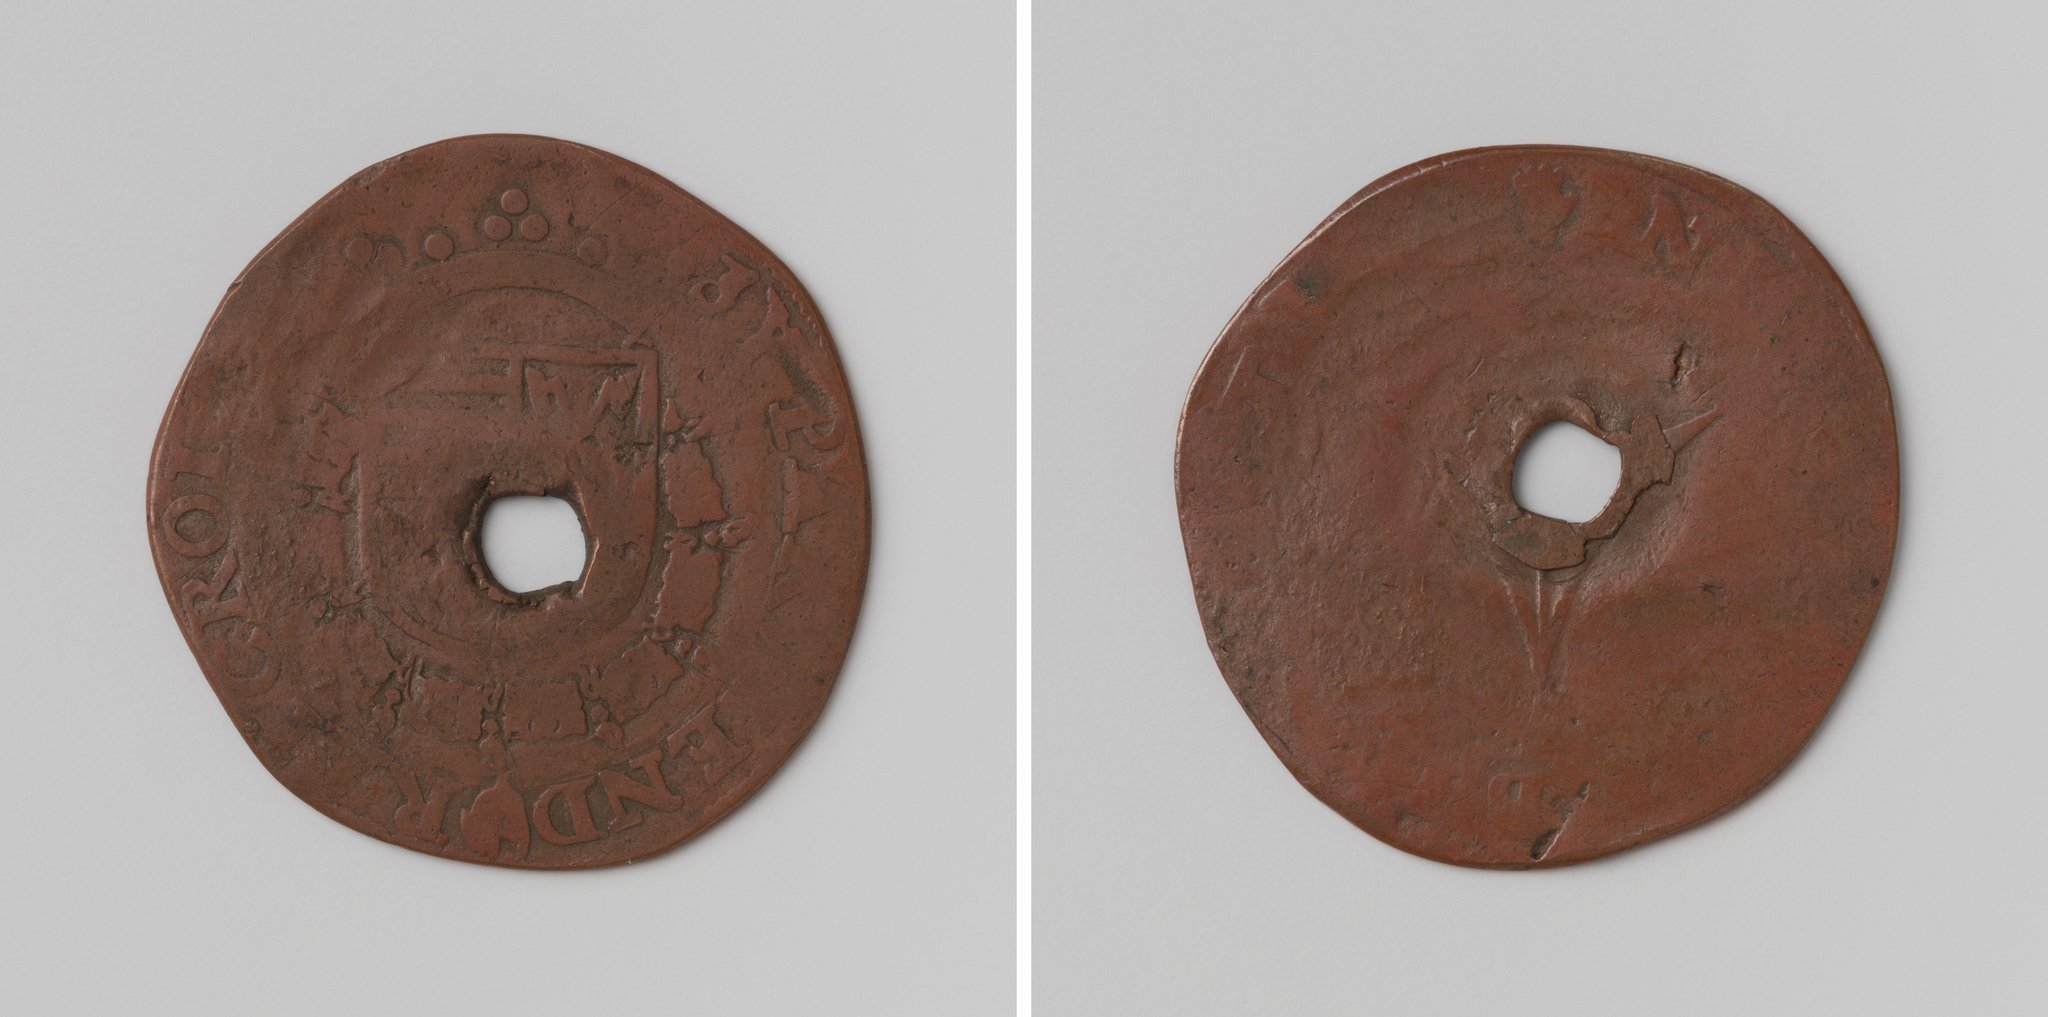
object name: jeton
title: Filips III van Croy, hertog van Aarschot, prins van Chimay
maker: Anonymous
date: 1567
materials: copper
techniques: striking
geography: antwerp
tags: venice, earl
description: Koperen penning met gat in midden. Voorzijde: gekroond wapenschild, omhangen met de orde van het Gulden Vlies binnen omschrift. Keerzijde: voetangel binnen omschrift